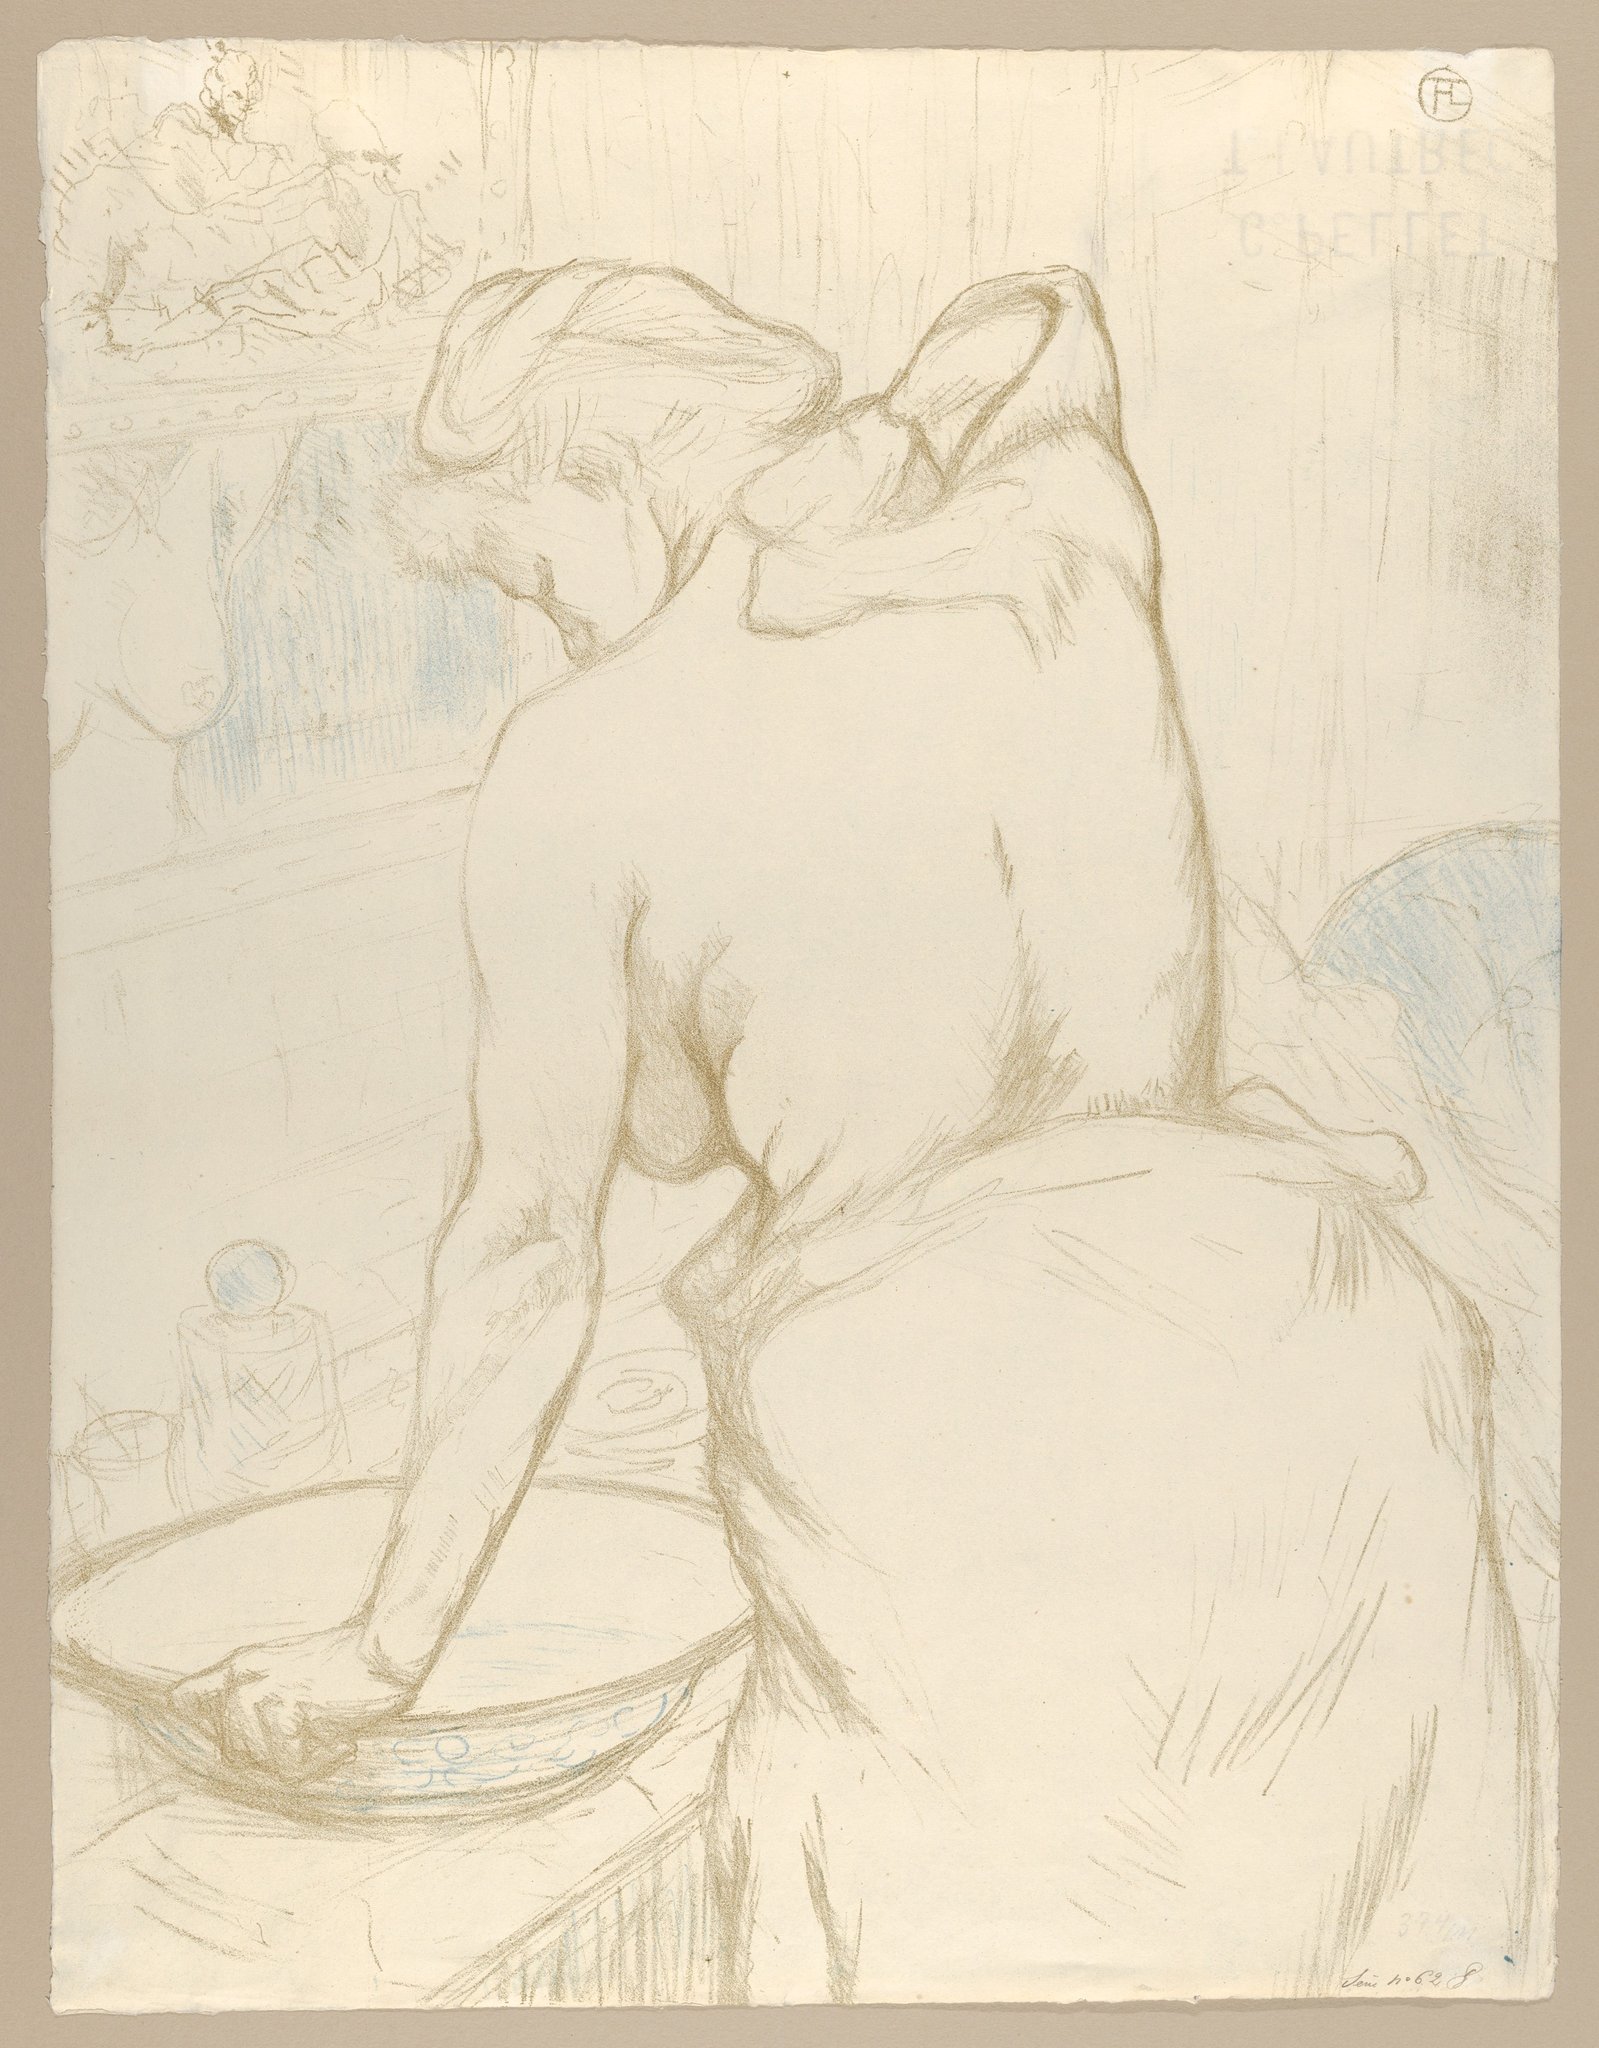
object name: print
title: Washing, from "Elles"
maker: henri de toulouse-lautrec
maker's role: artist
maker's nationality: french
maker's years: 1864-1901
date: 1896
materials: paper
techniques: lithograph, printing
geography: france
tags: female nudes,washing